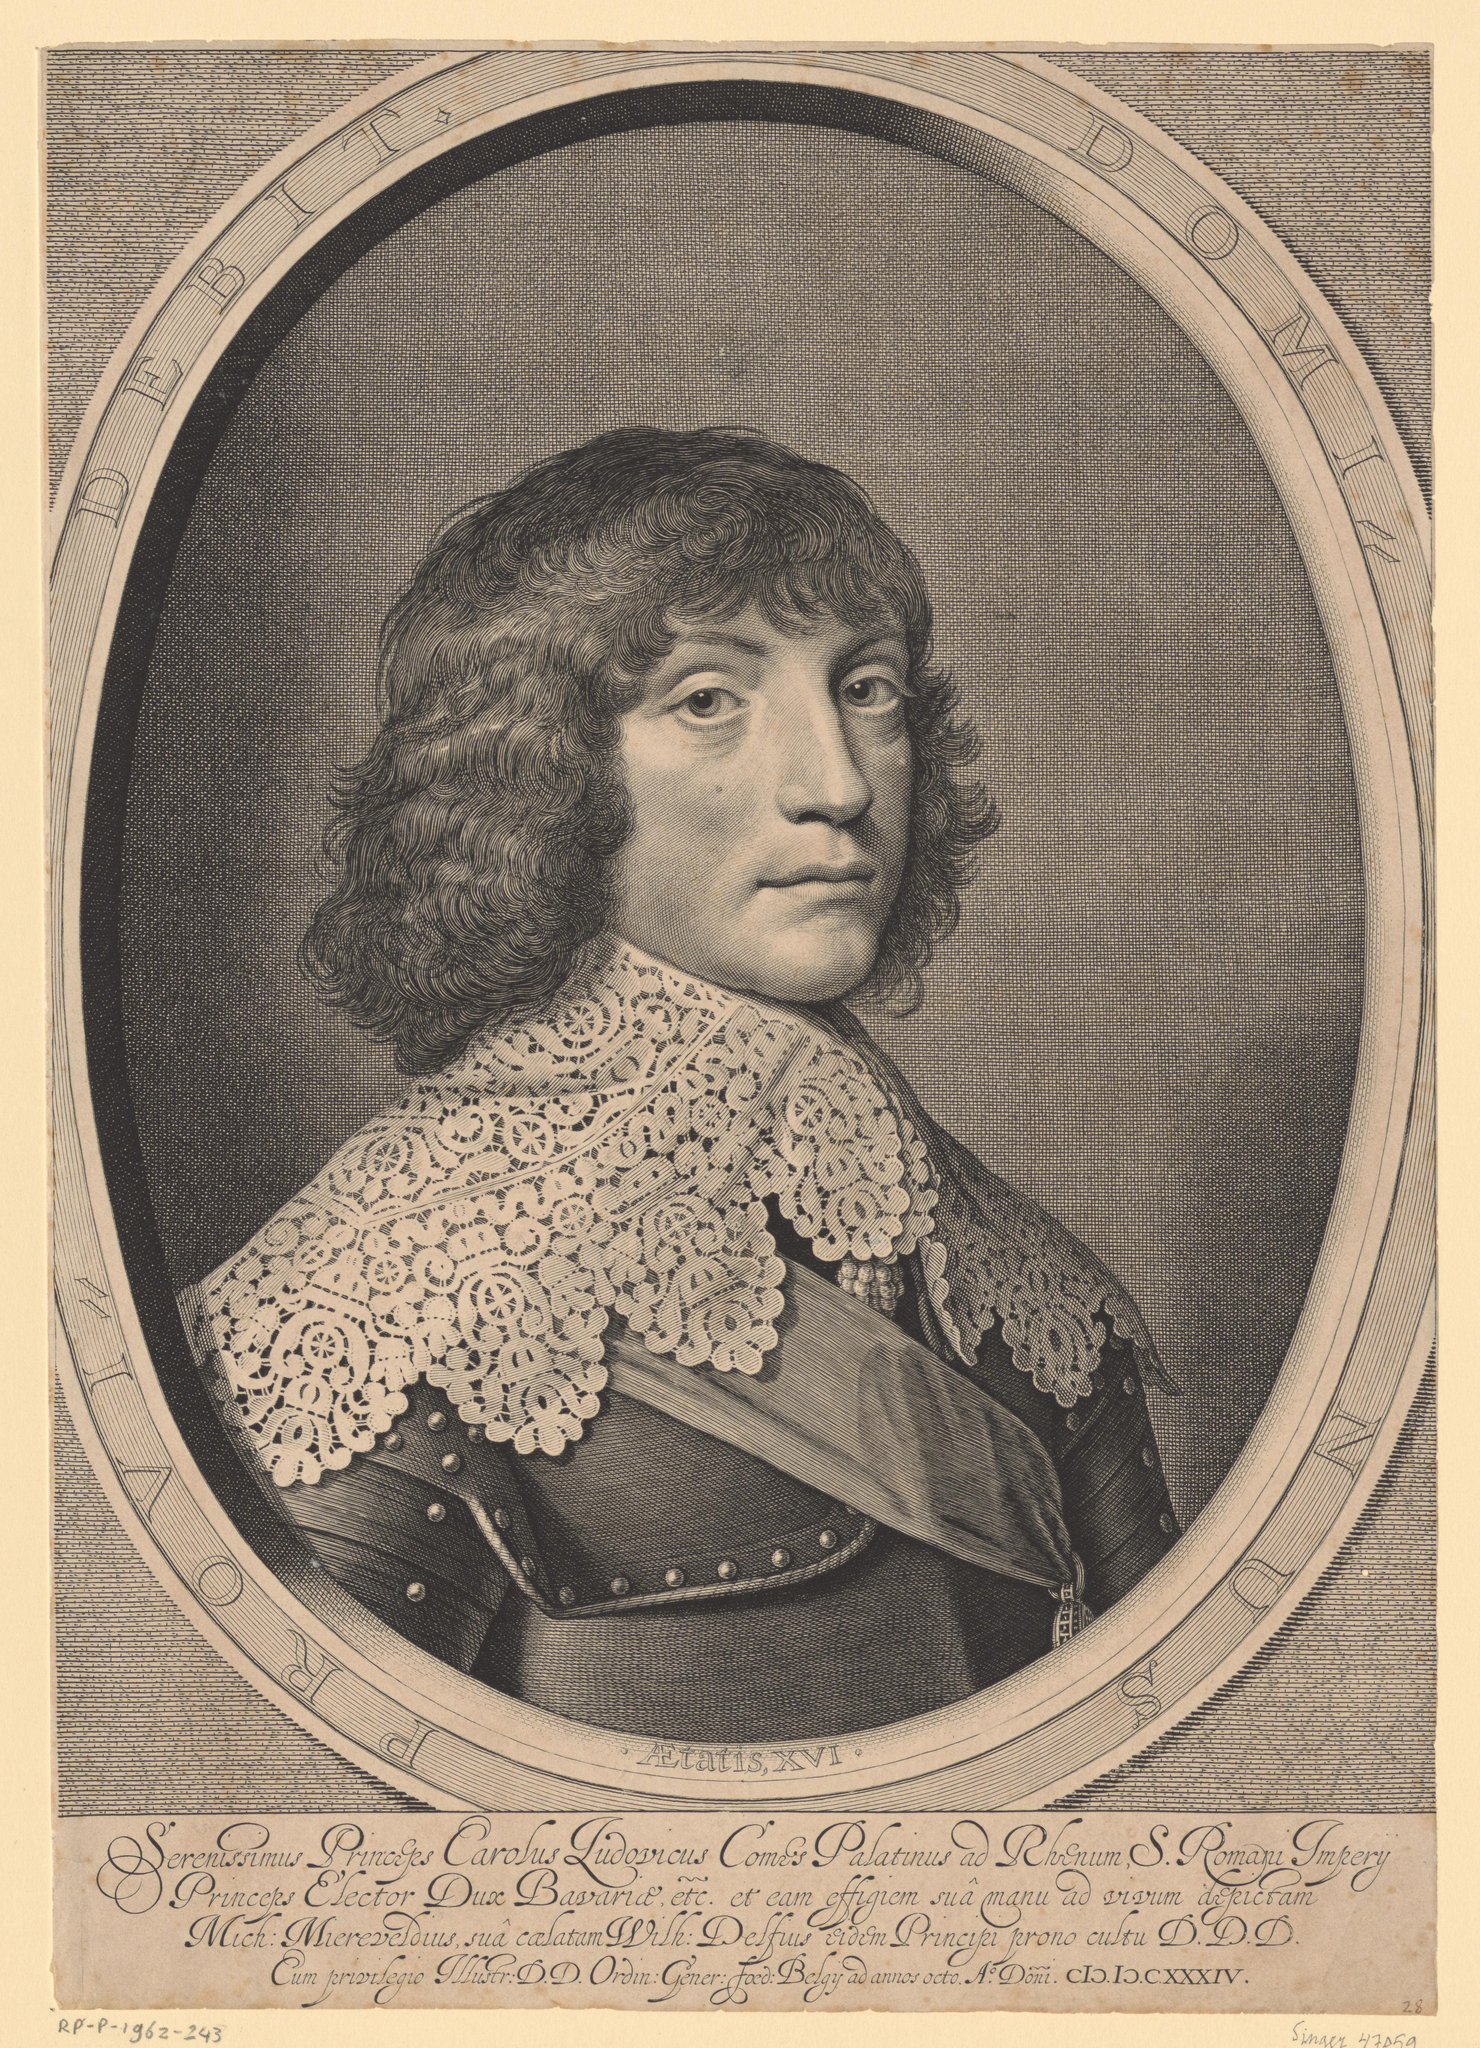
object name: print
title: Portret van Karel Lodewijk, keurvorst van de Palts, op 16-jarige leeftijd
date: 1634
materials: paper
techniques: engraving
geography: delft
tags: historical persons, ruler, sovereign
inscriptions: inscription: ‘28’